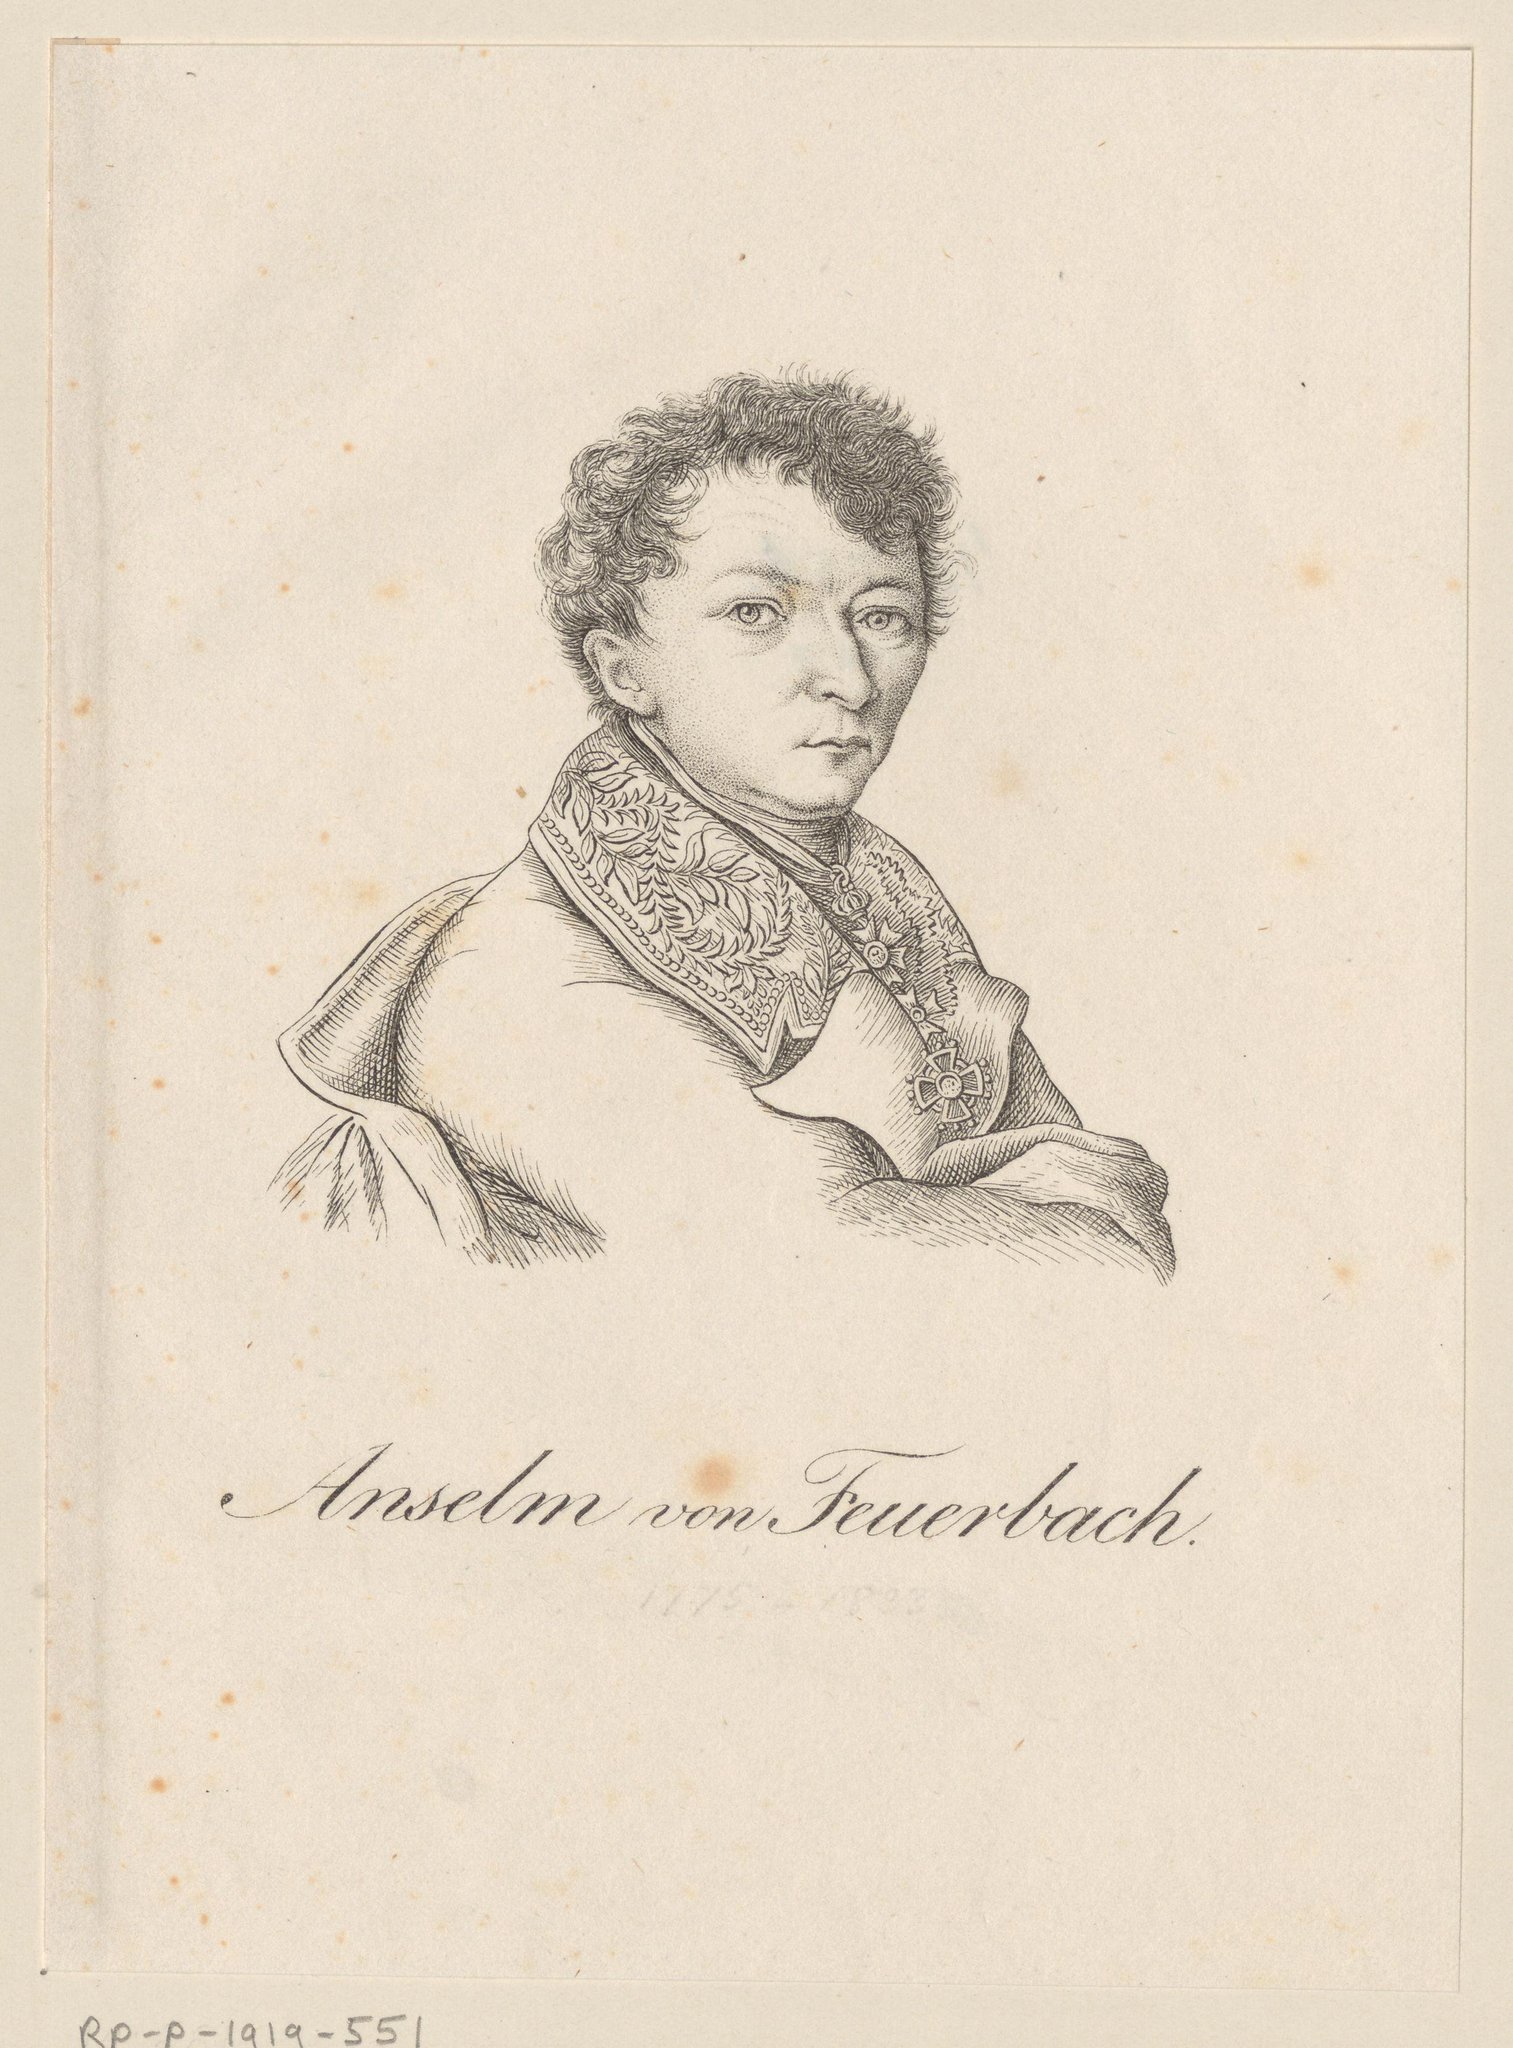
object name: print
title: Portret van Paul Johann Anselm von Feuerbach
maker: Anonymous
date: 1800-1850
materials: paper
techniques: etching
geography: germany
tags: historical persons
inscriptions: collector's mark: Lugt 2228